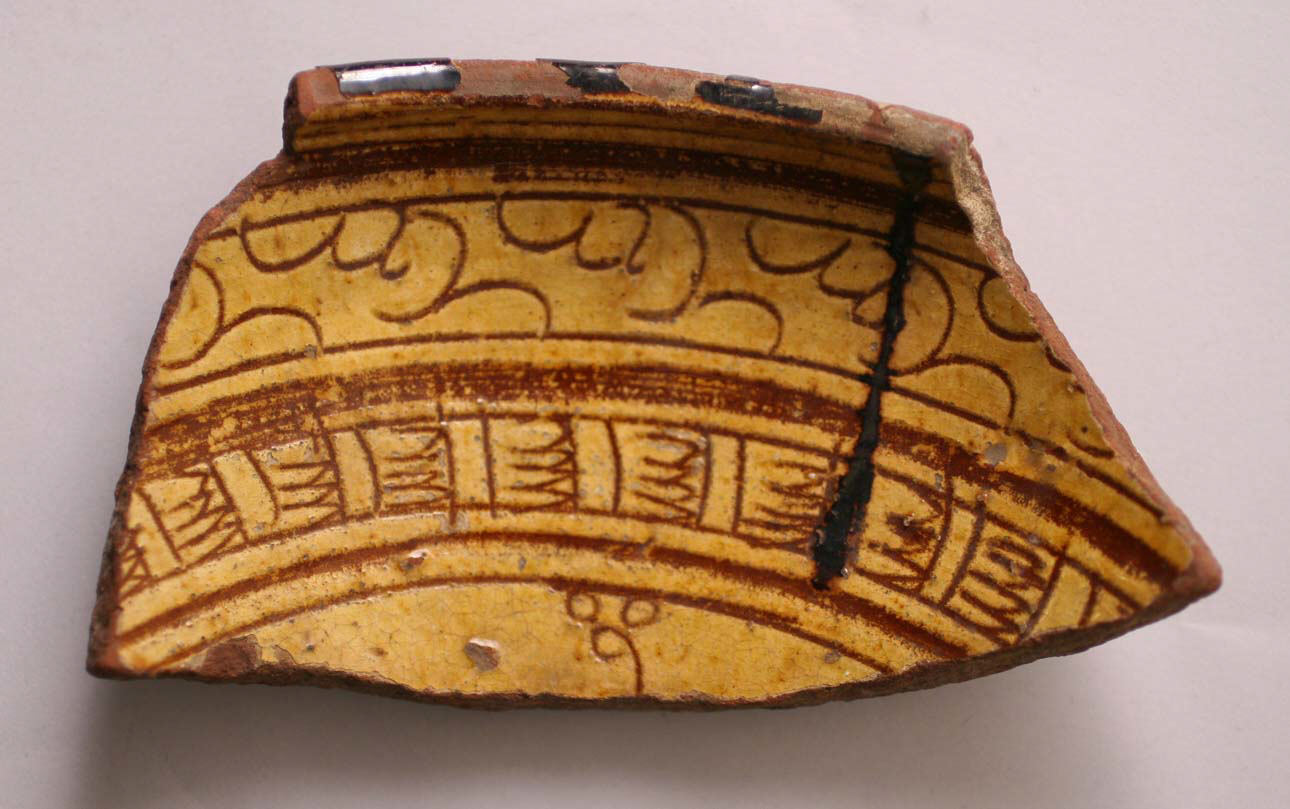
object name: fragment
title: Ceramic Fragment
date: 1301-1500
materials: earthenware, glaze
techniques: coloring, incising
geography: egypt